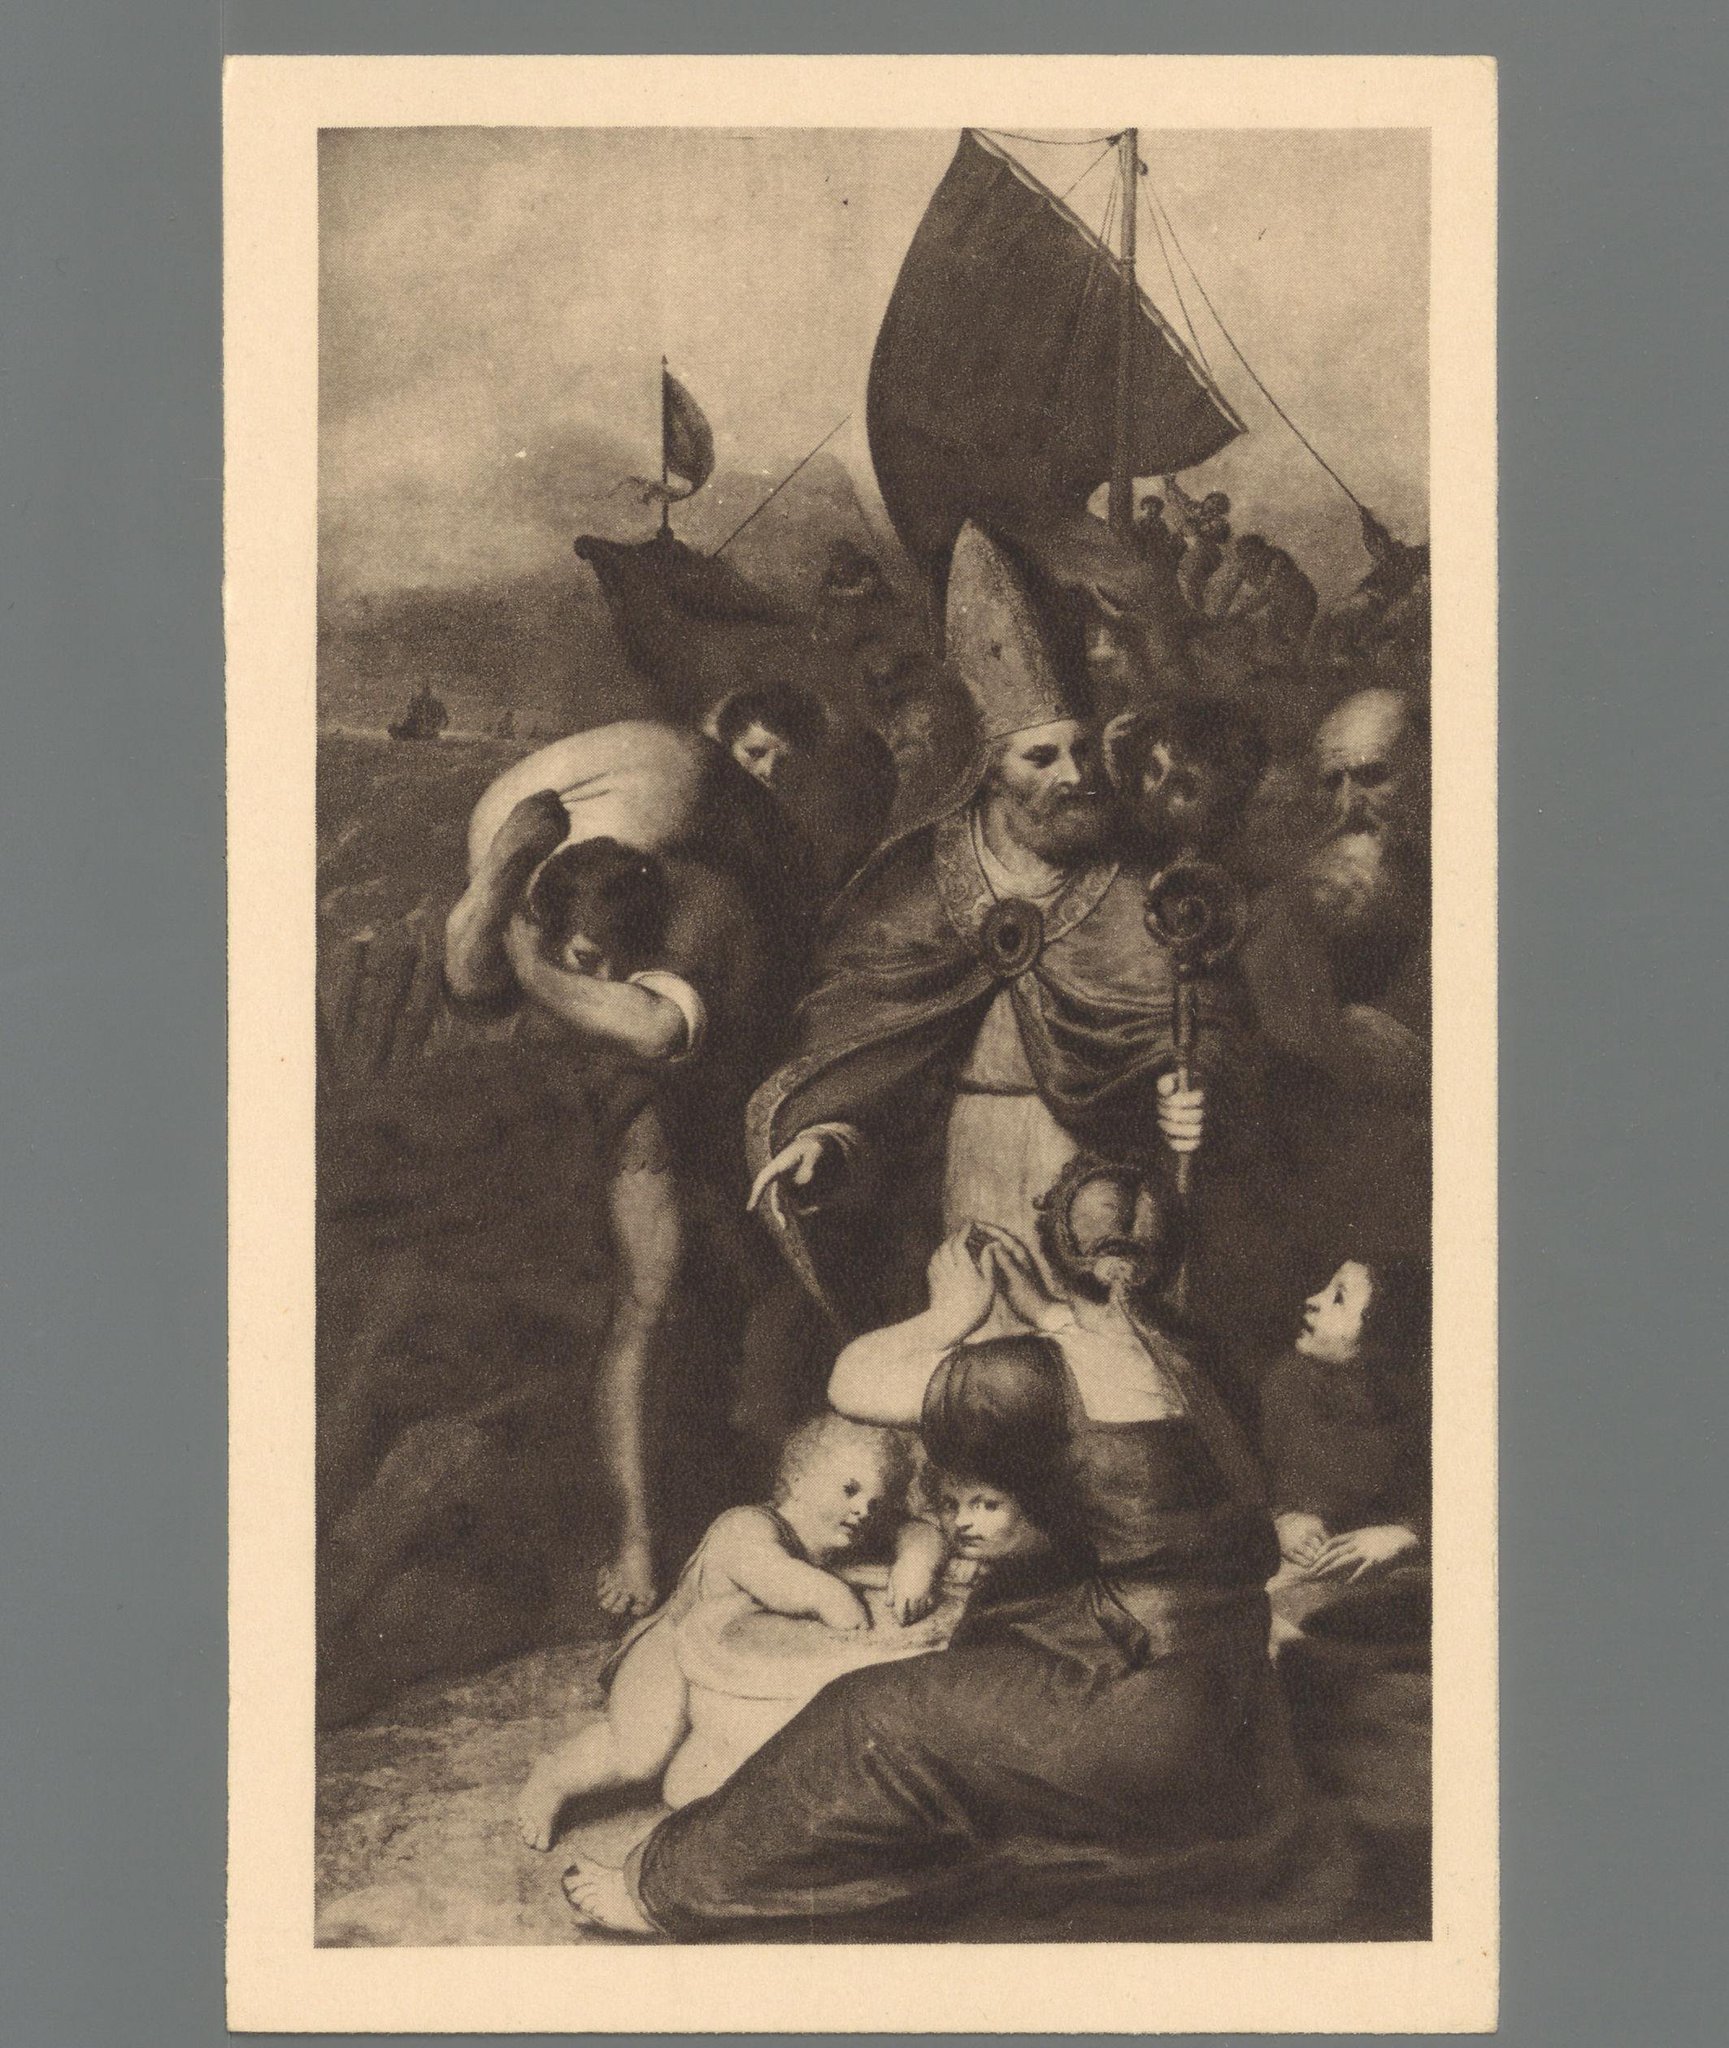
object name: reproduction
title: Otto van Veen (1558-1629). De H. Nicolaas laat bij hongersnood graan uitdeelen - Antwerpen, Museum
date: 1928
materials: cardboard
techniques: rotogravure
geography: milan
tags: permanent exhibition, museum, picture, painting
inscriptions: collector's mark: ‘AFE v S’